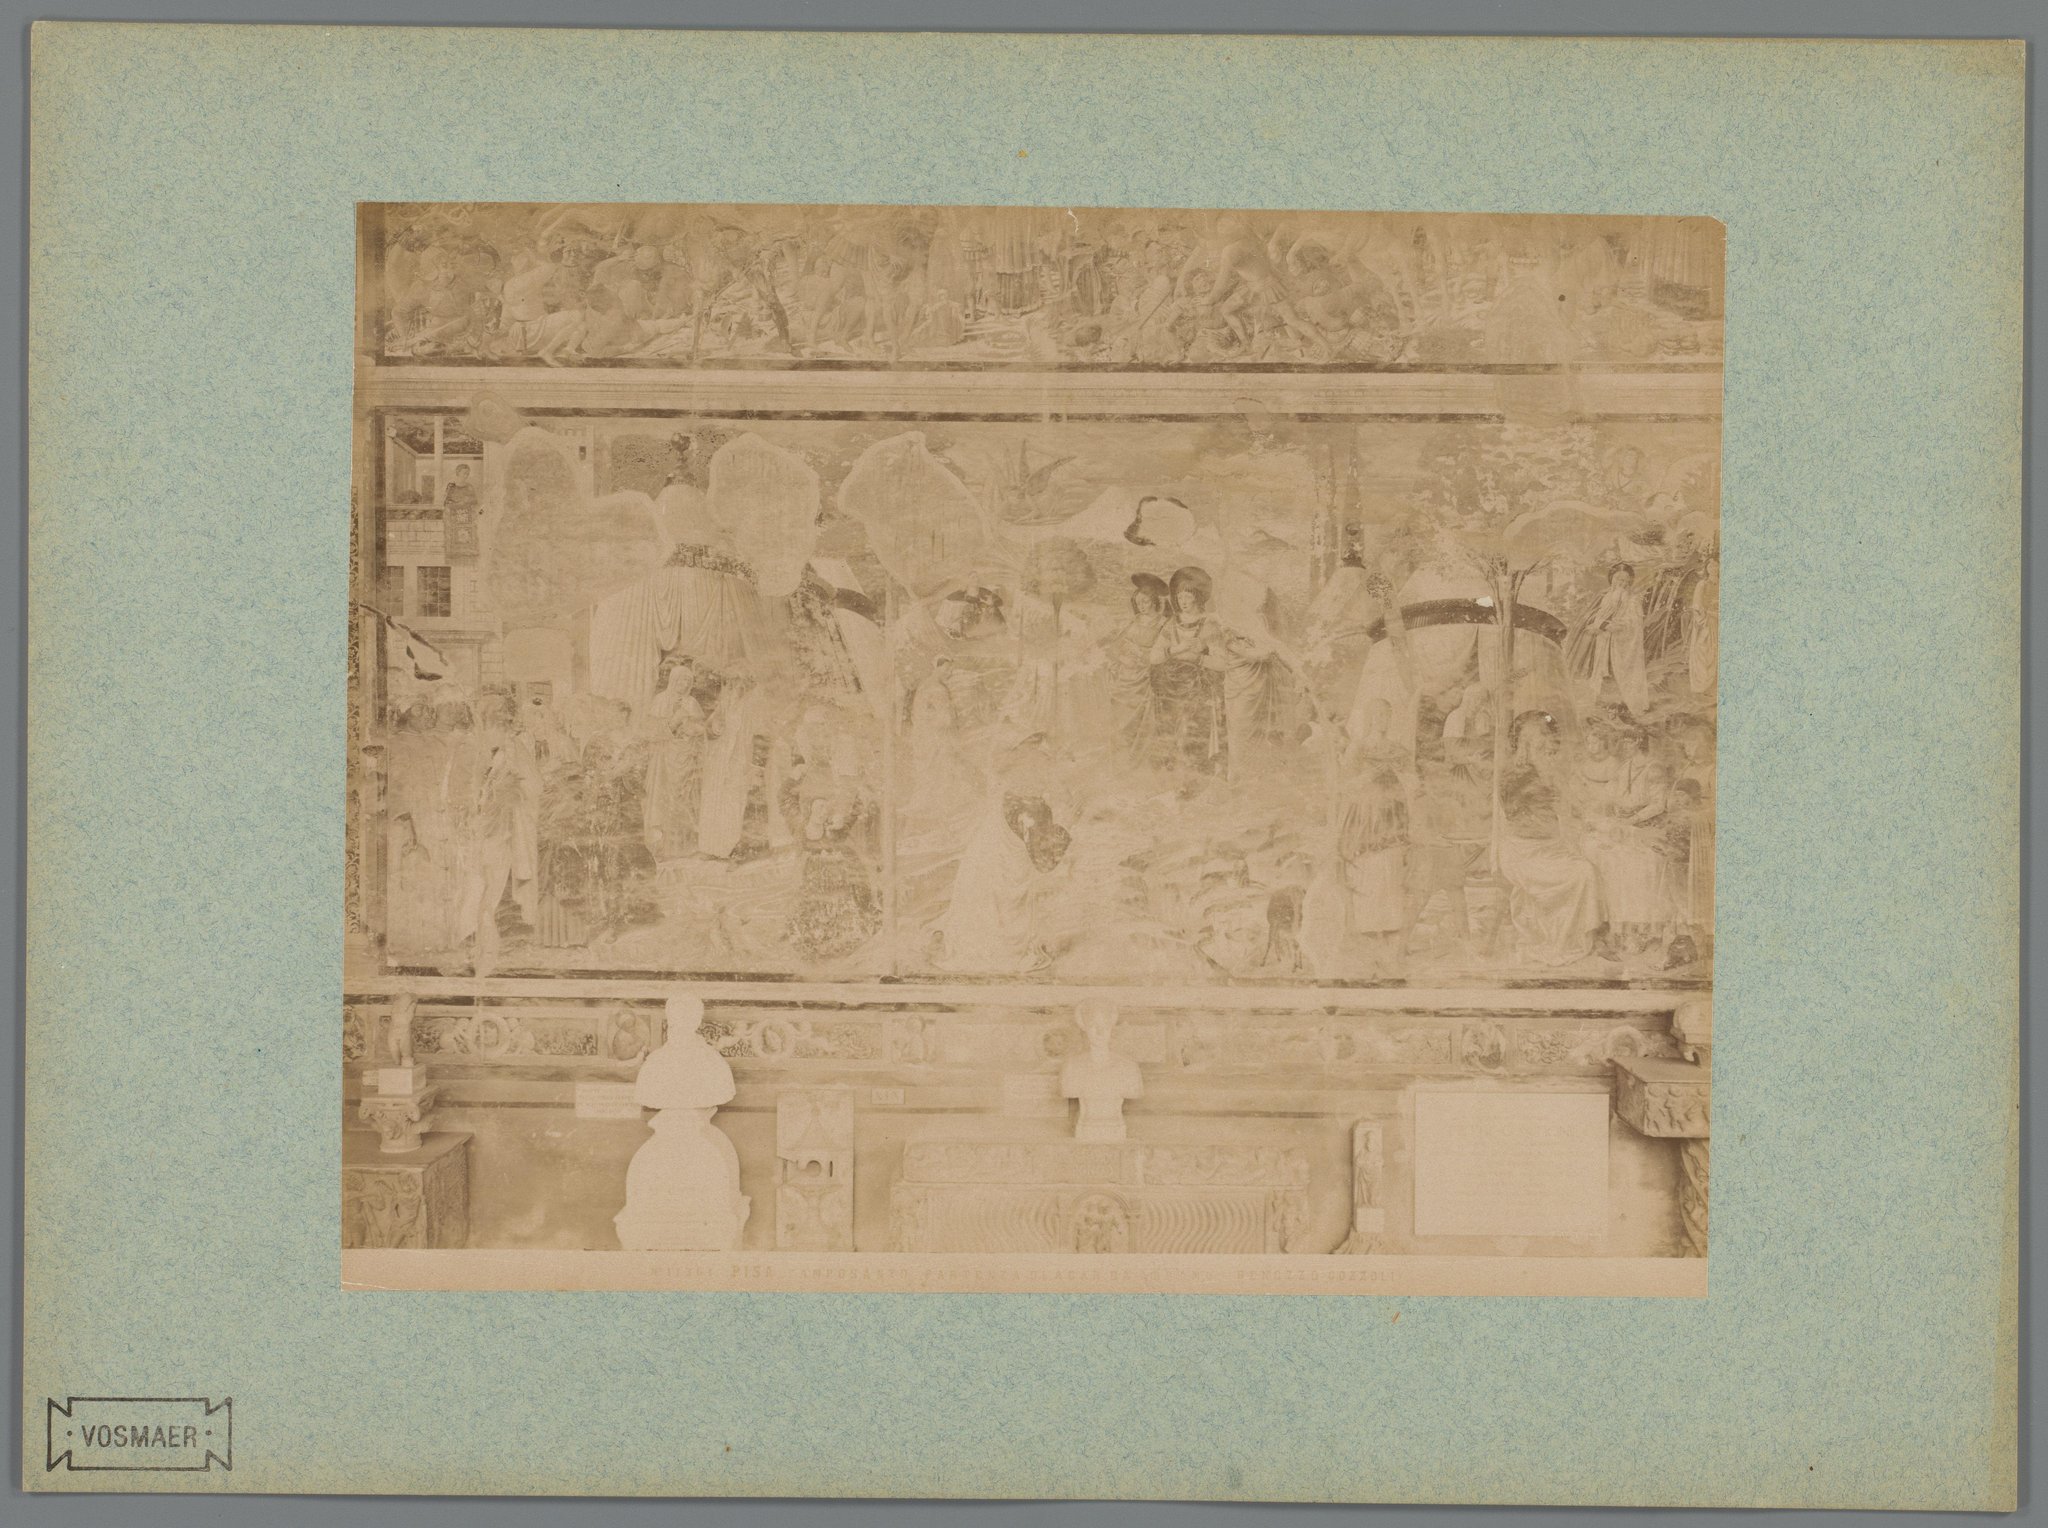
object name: photograph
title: Fotoreproductie van het fresco Hagar verlaat Abraham door Benozzo Gozzoli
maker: benozzo gozzoli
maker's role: draughtsman, painter, sculptor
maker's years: 1421-1497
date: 1852-1900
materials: cardboard, paper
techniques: albumen print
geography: pisa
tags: abraham and hagar (genesis 16), wall-covering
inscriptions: collector's mark: ‘VOSMAER’, number: ‘N 11361’